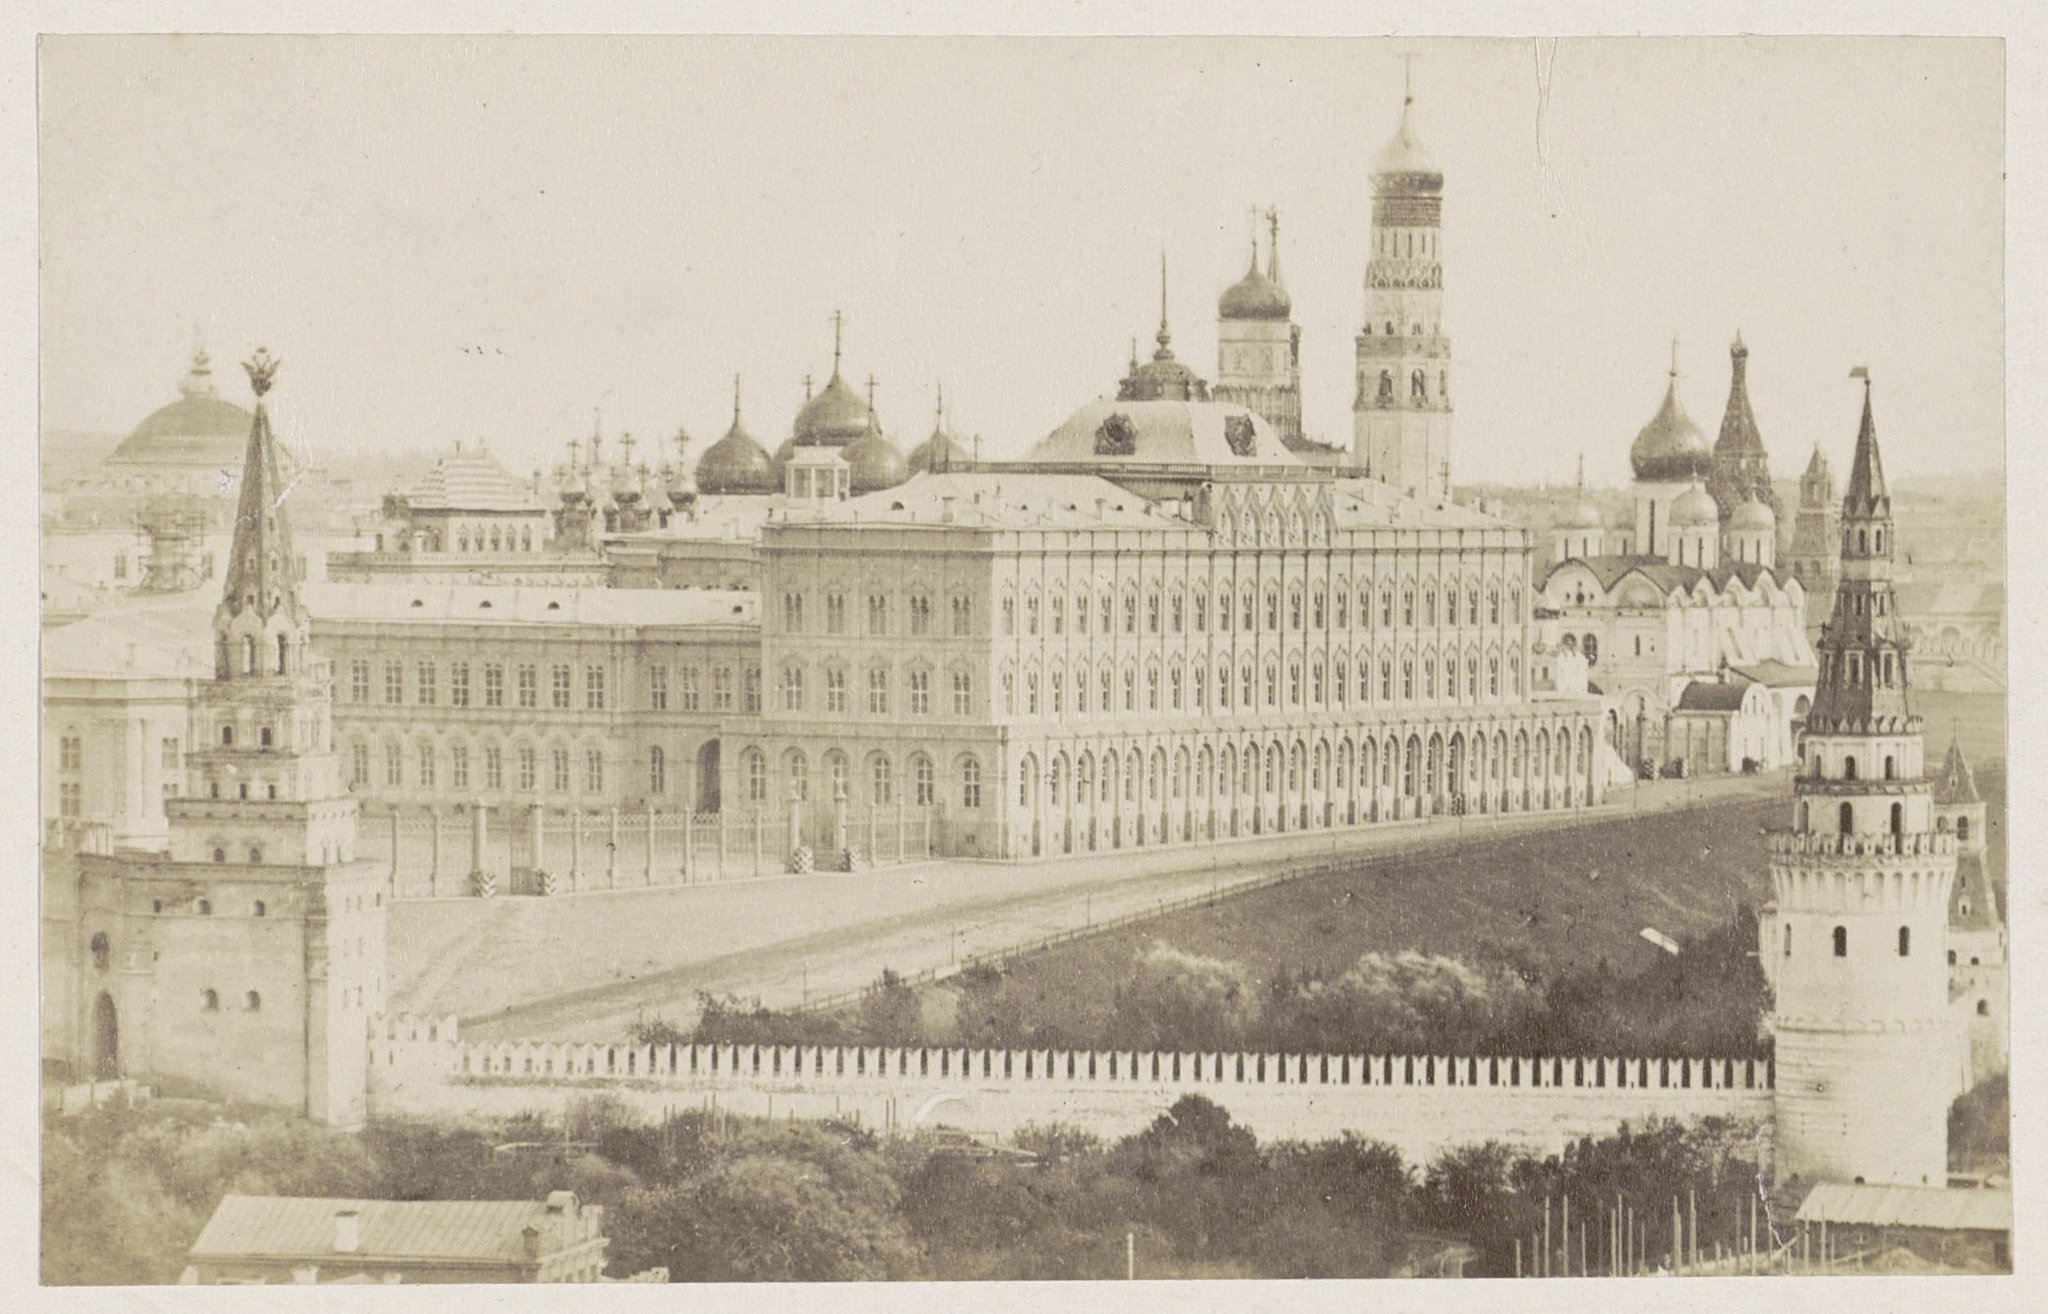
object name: photograph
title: Kreml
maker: Anonymous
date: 1878-1890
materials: photographic support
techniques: albumen print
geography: moscow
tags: fortress, palace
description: Onderdeel van Reisalbum Europese steden, vermoedelijk Zweeds.